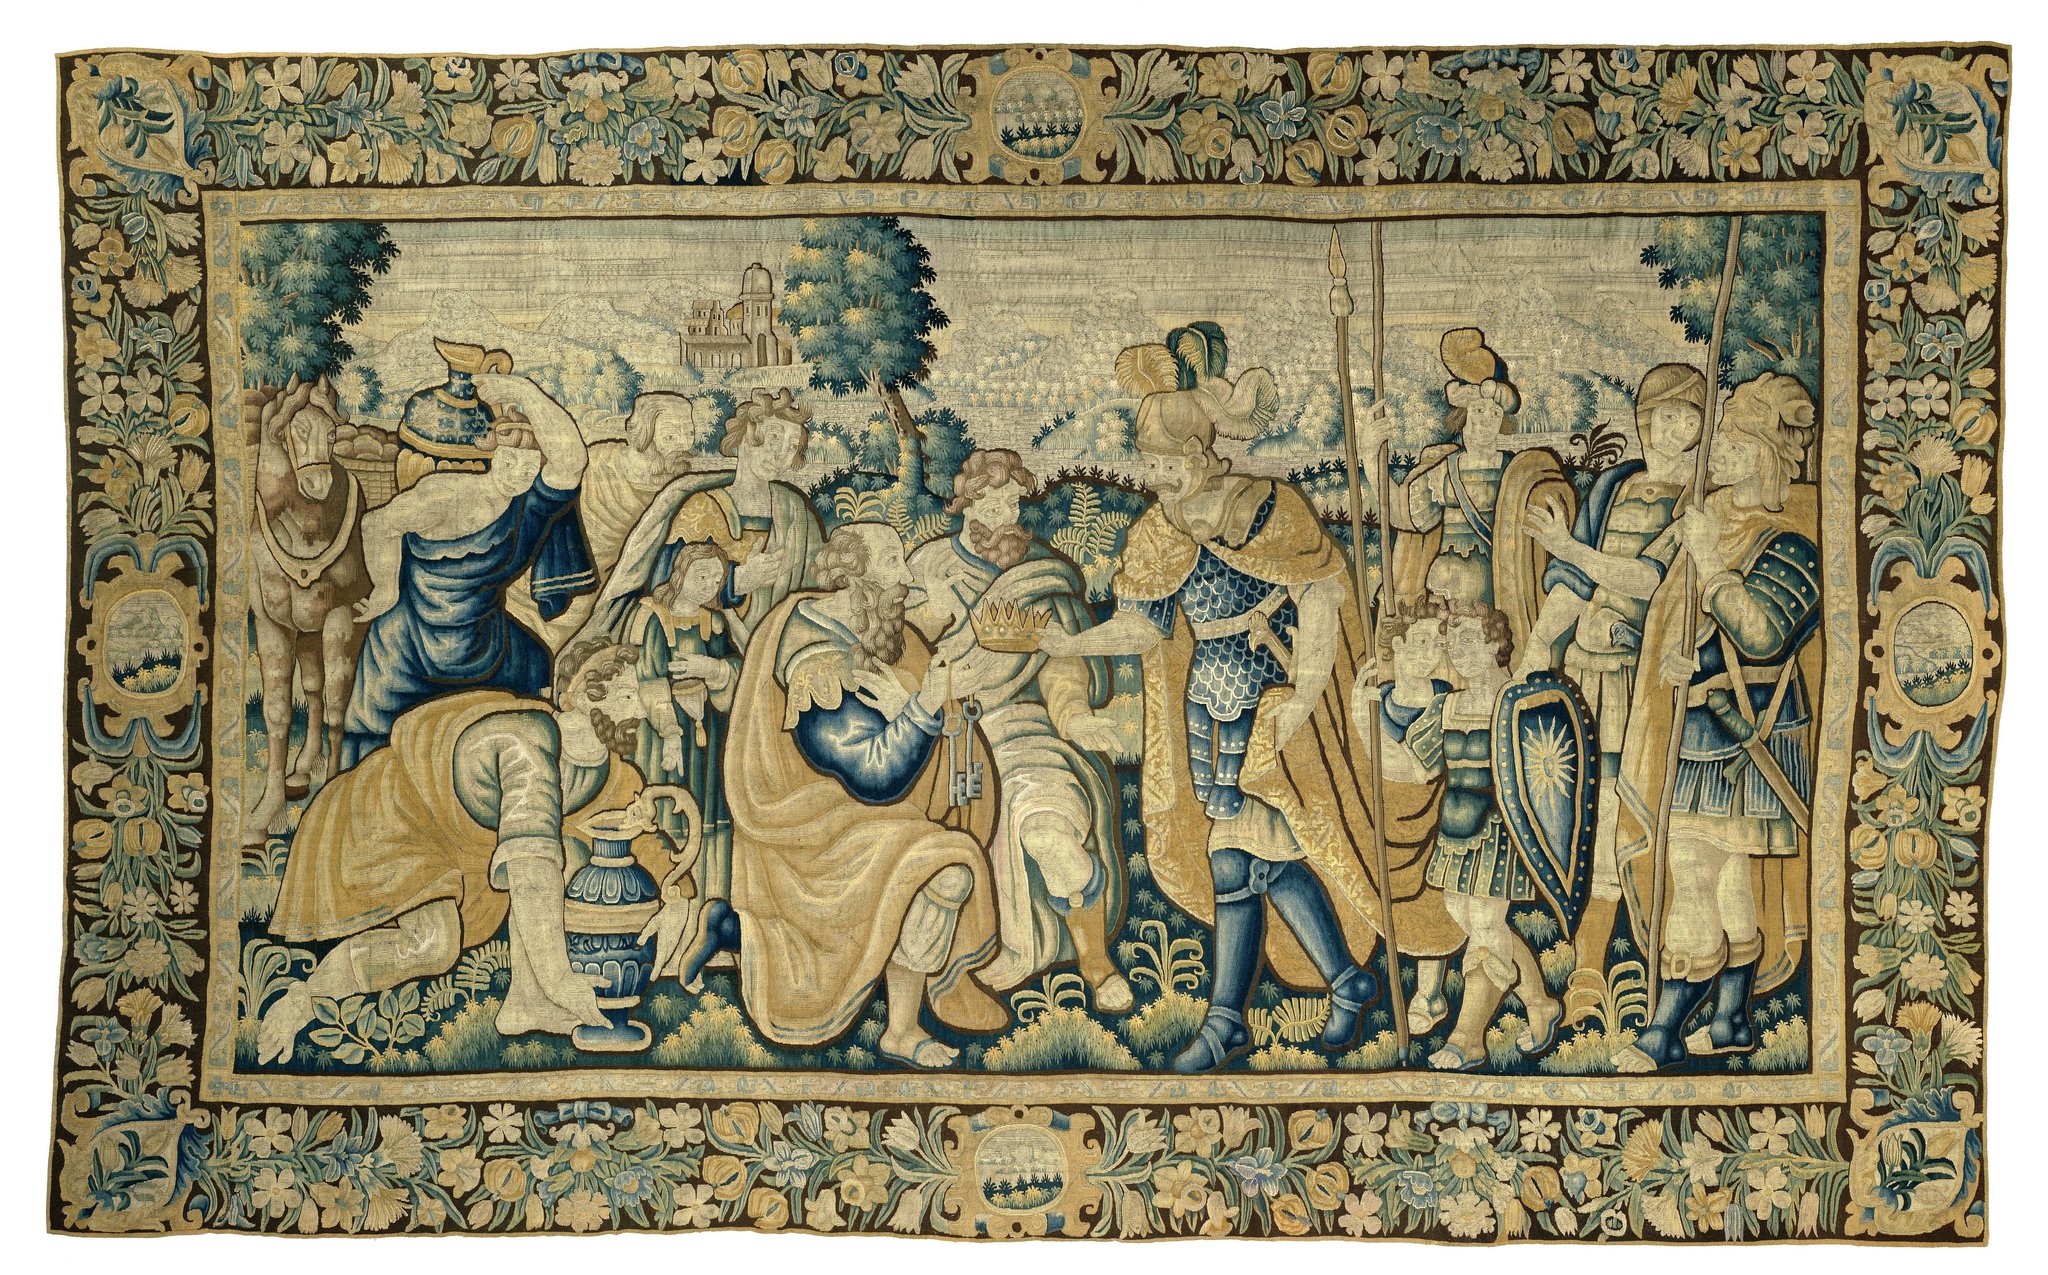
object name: tapestry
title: De verslagen koning Porus verschijnt voor Alexander, die hem zijn heerschappij terug geeft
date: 1625-1650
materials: silk, wool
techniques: tapestry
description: Wandtapijt met Alexander die aan Porus de koningskroon teruggeeft, uit een serie met de geschiedenis van Alexander de Grote.